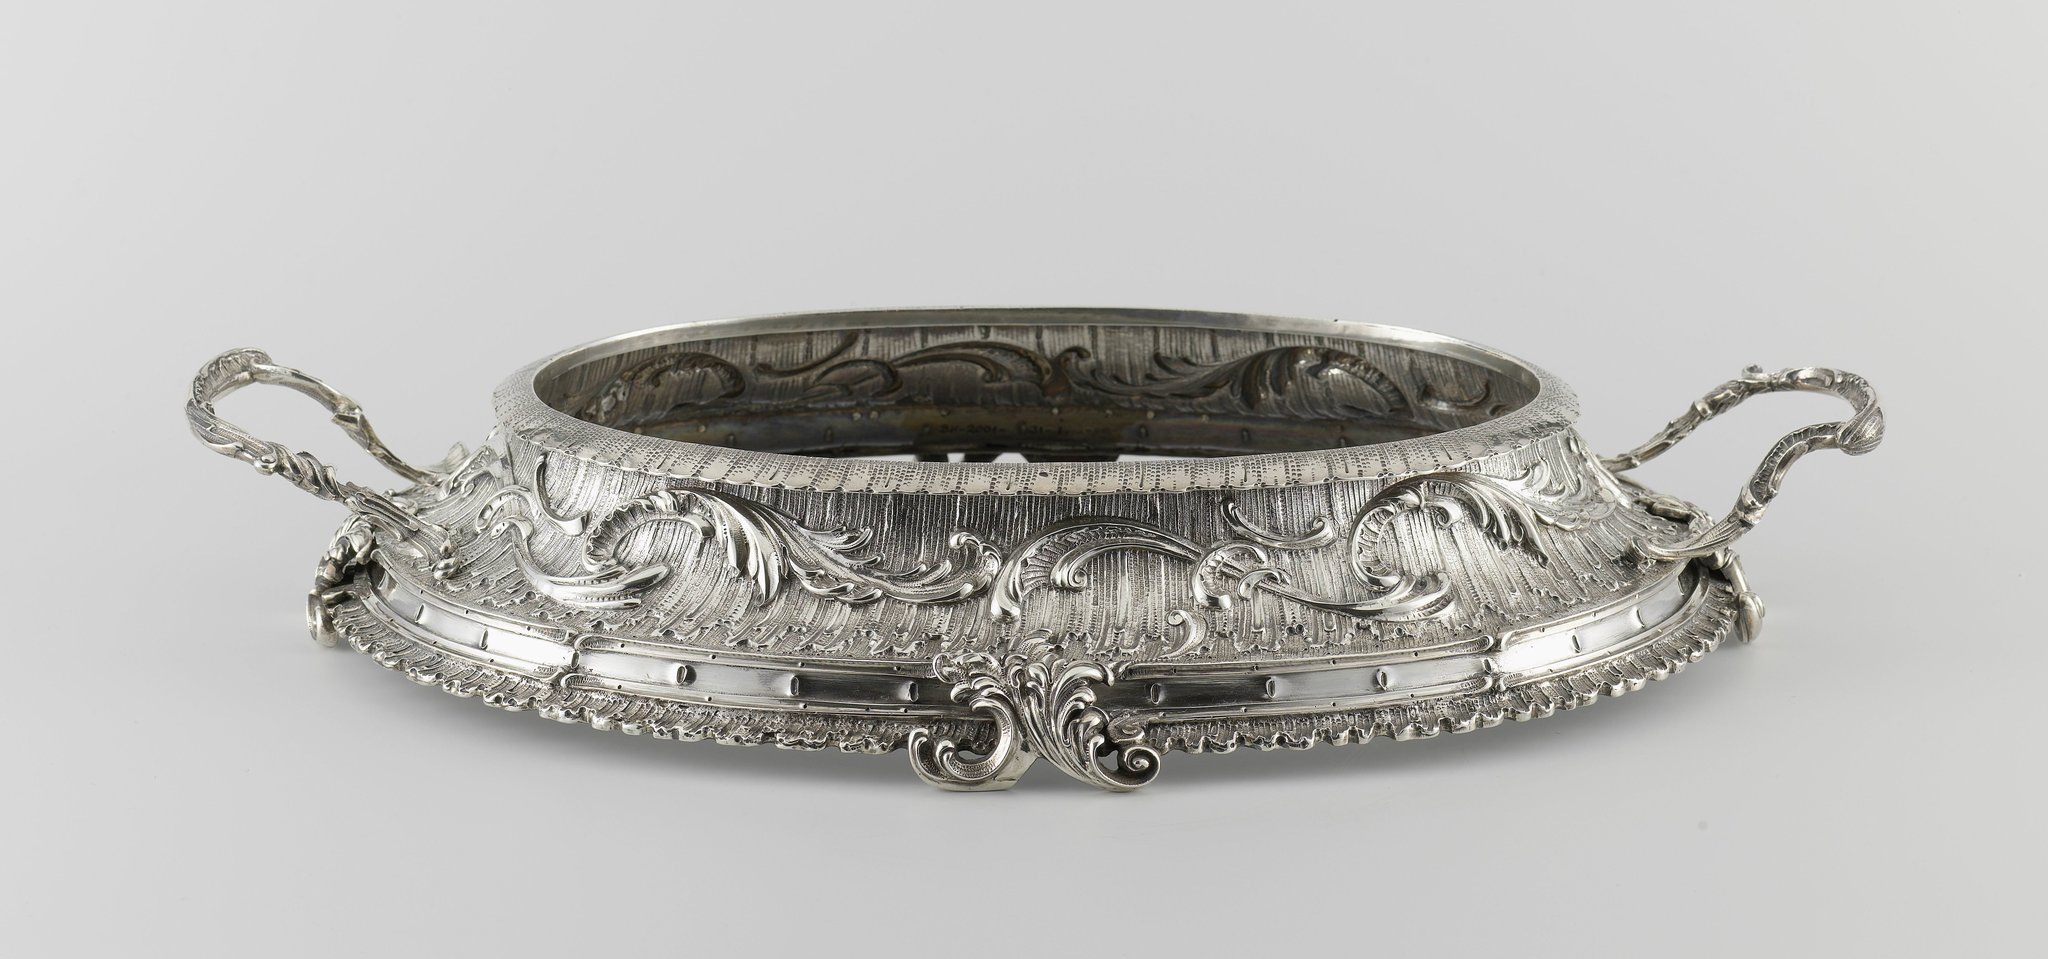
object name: tafelmiddenstuk, milieu de table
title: Middenstuk, deel van een ensemble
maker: karel sluijterman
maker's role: designer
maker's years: 1863-1931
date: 1891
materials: silver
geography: amsterdam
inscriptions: alloy mark, assayer's mark, date letter: ‘G’, assay office mark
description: Middenstuk van zilver, deel van een ensemble